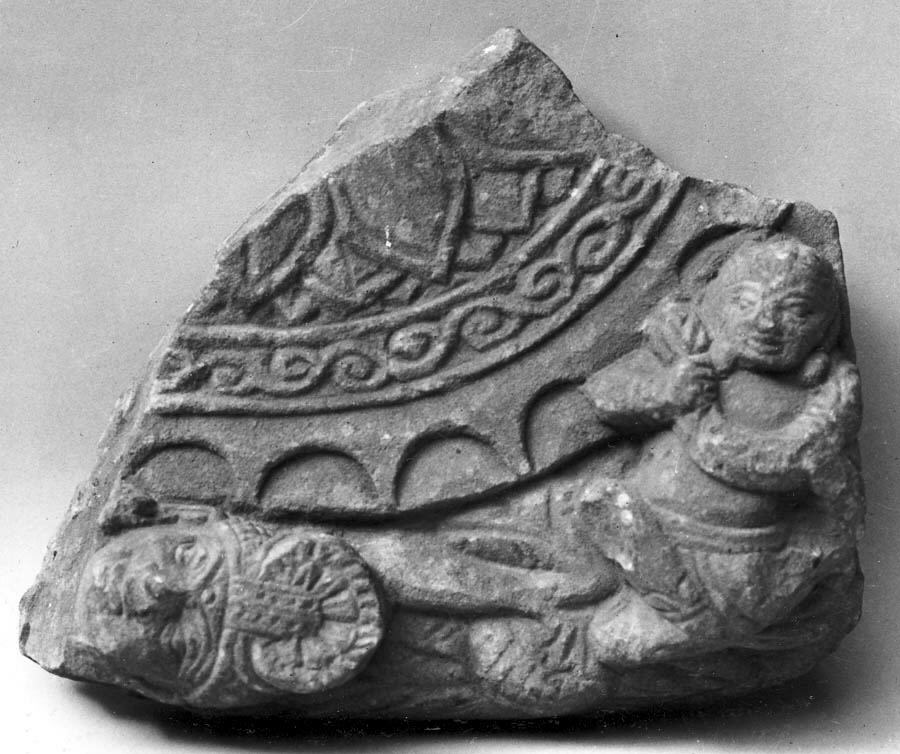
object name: relief fragment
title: Bodhisattva and Yaksha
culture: indian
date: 101-300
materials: stone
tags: kushan,mathura,buddhism,bodhisattvas